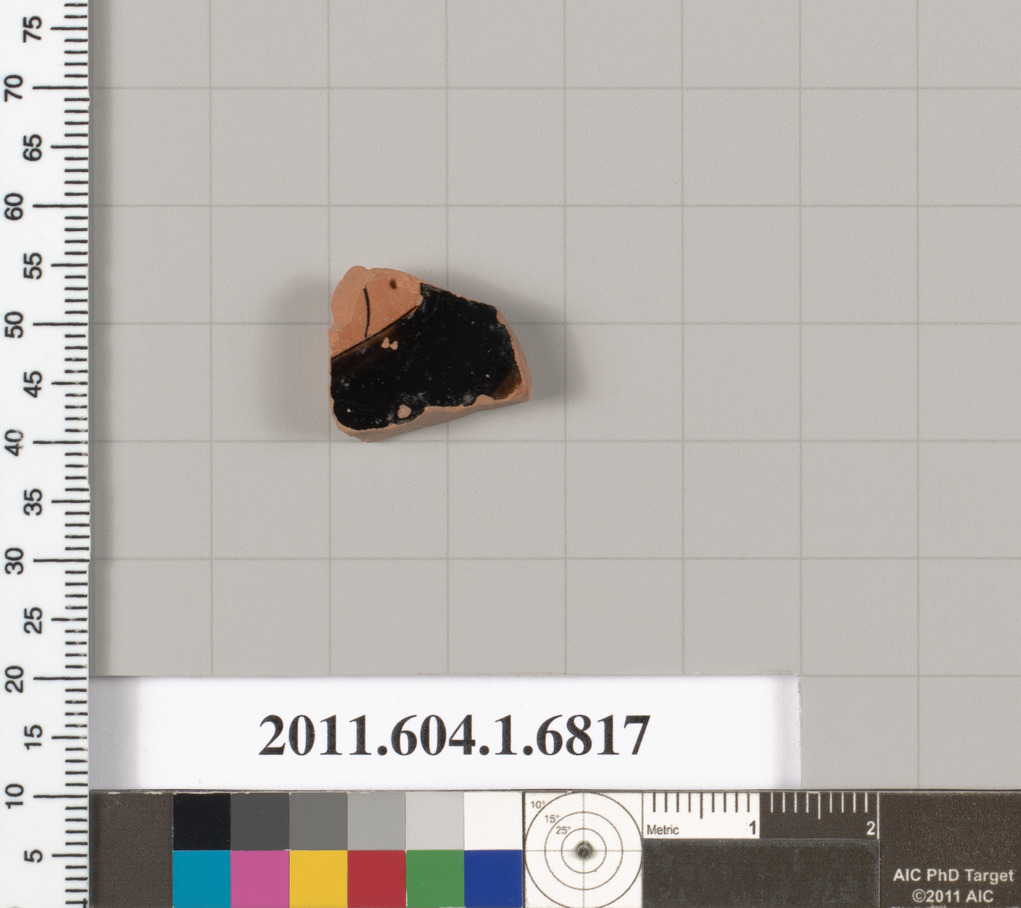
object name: kylix fragment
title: Terracotta fragment of a kylix (drinking cup)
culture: greek, attic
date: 490-470 BCE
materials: terracotta